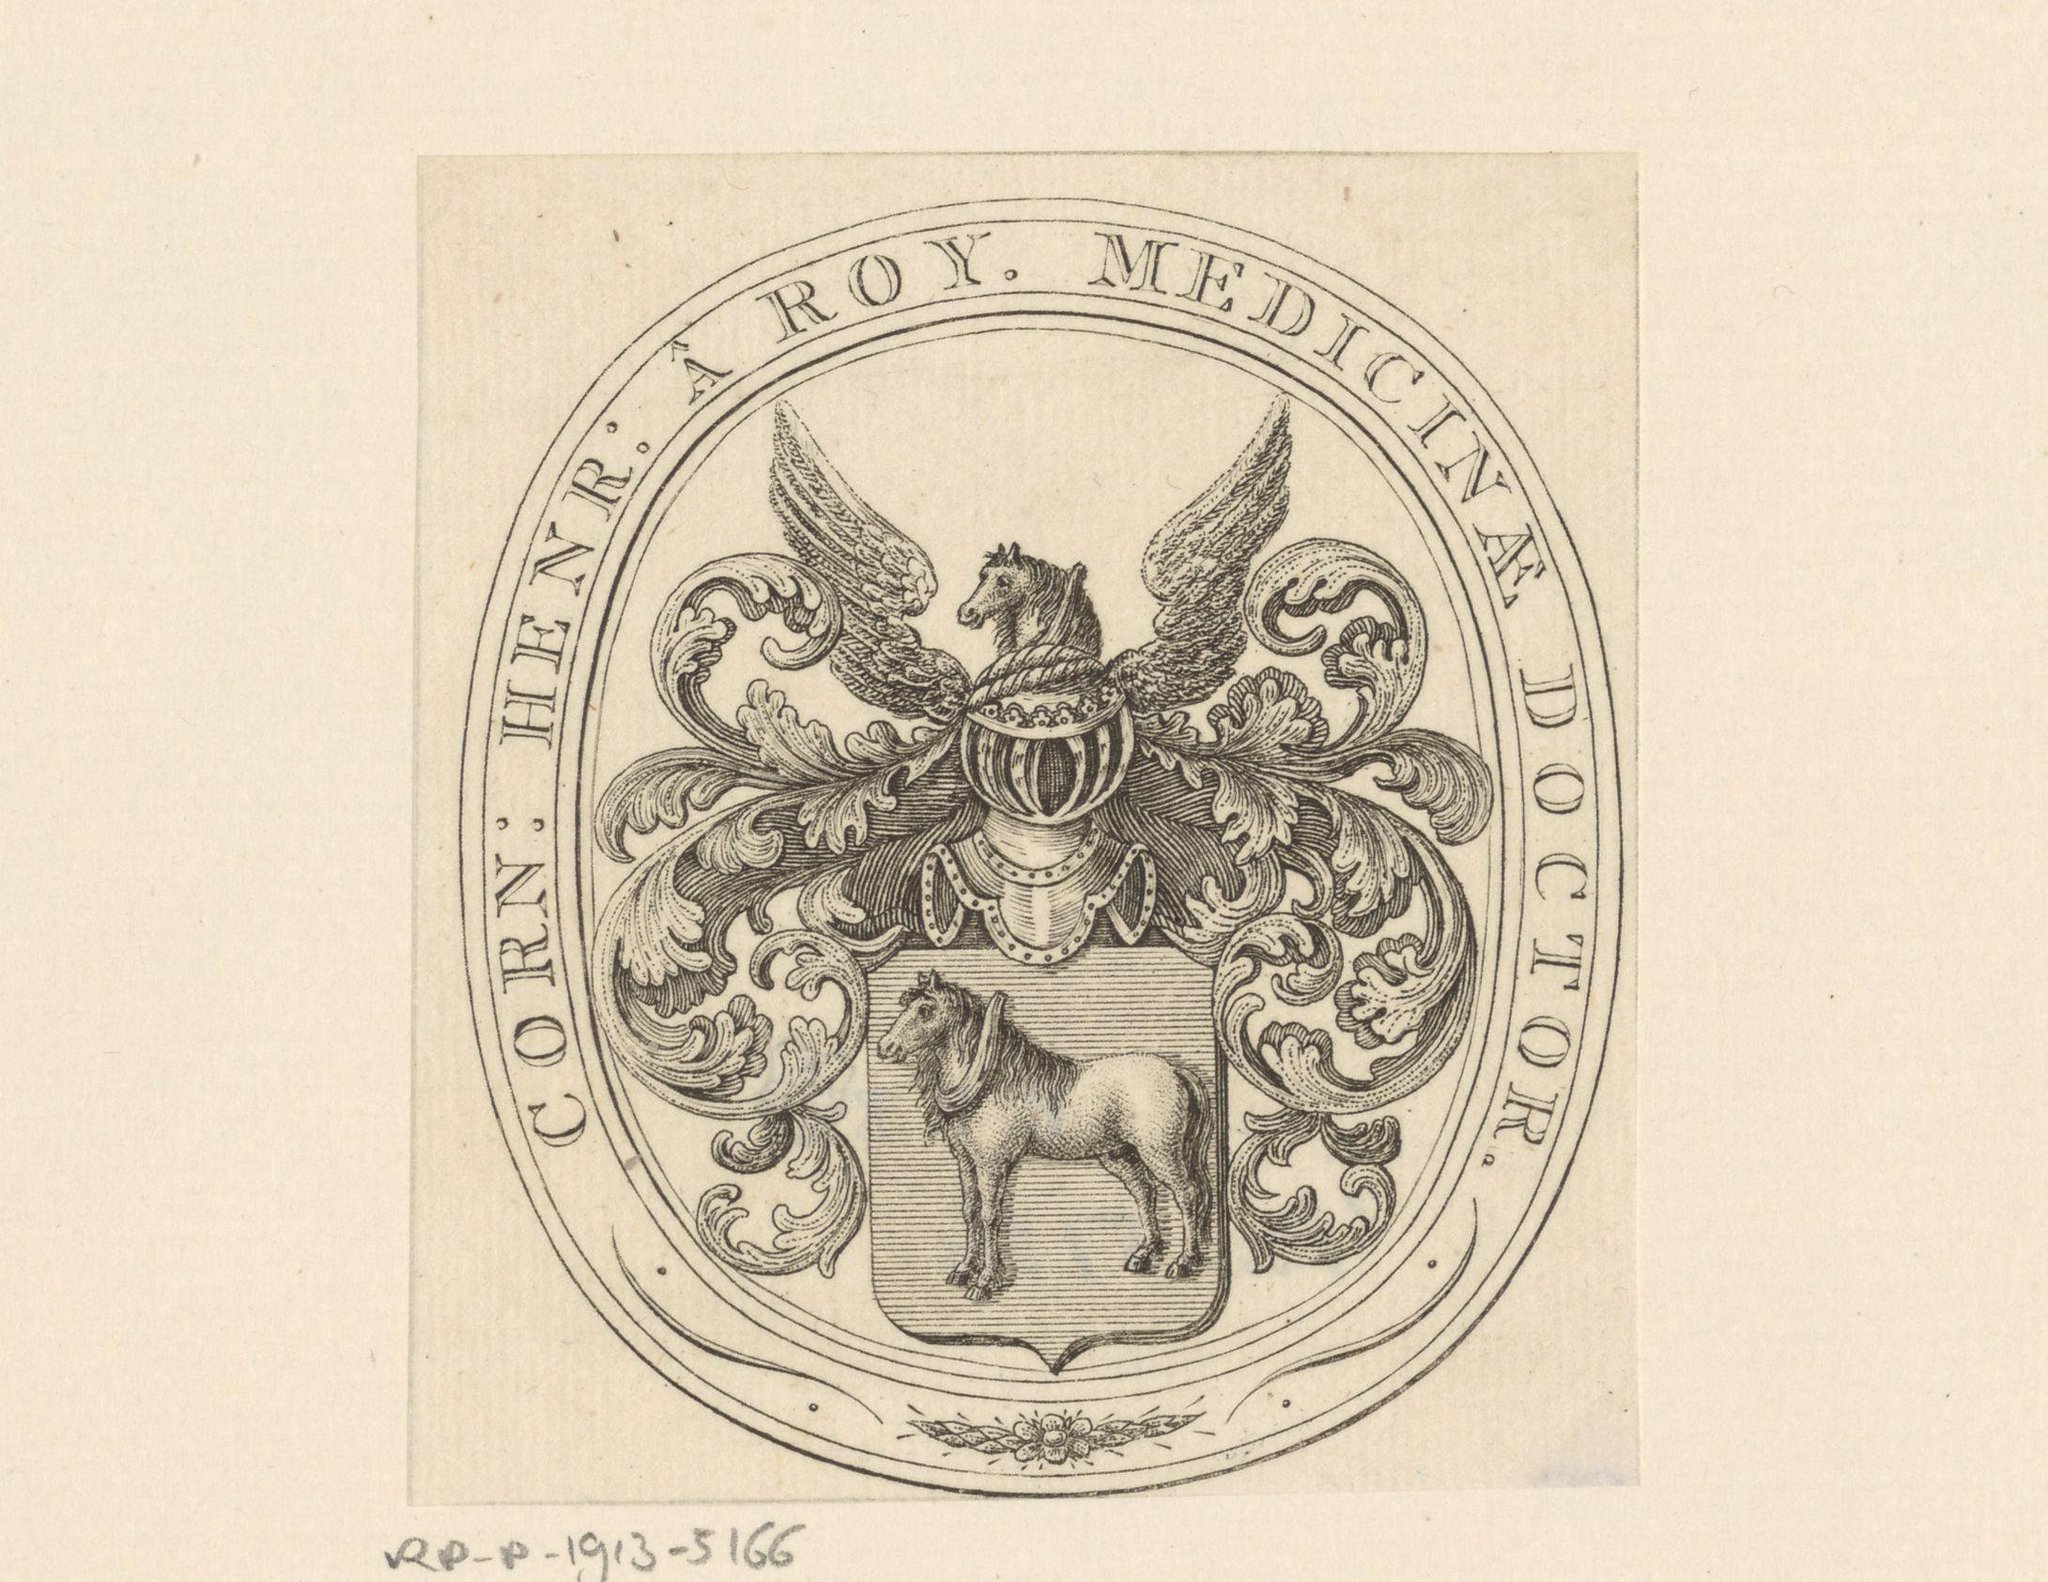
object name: bookplate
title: Corn: Henr: à Roy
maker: Anonymous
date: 1760-1833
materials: paper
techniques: etching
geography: netherlands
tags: horse, armorial bearing, heraldry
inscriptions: collector's mark: Lugt 2233, collector's mark: Lugt 2760